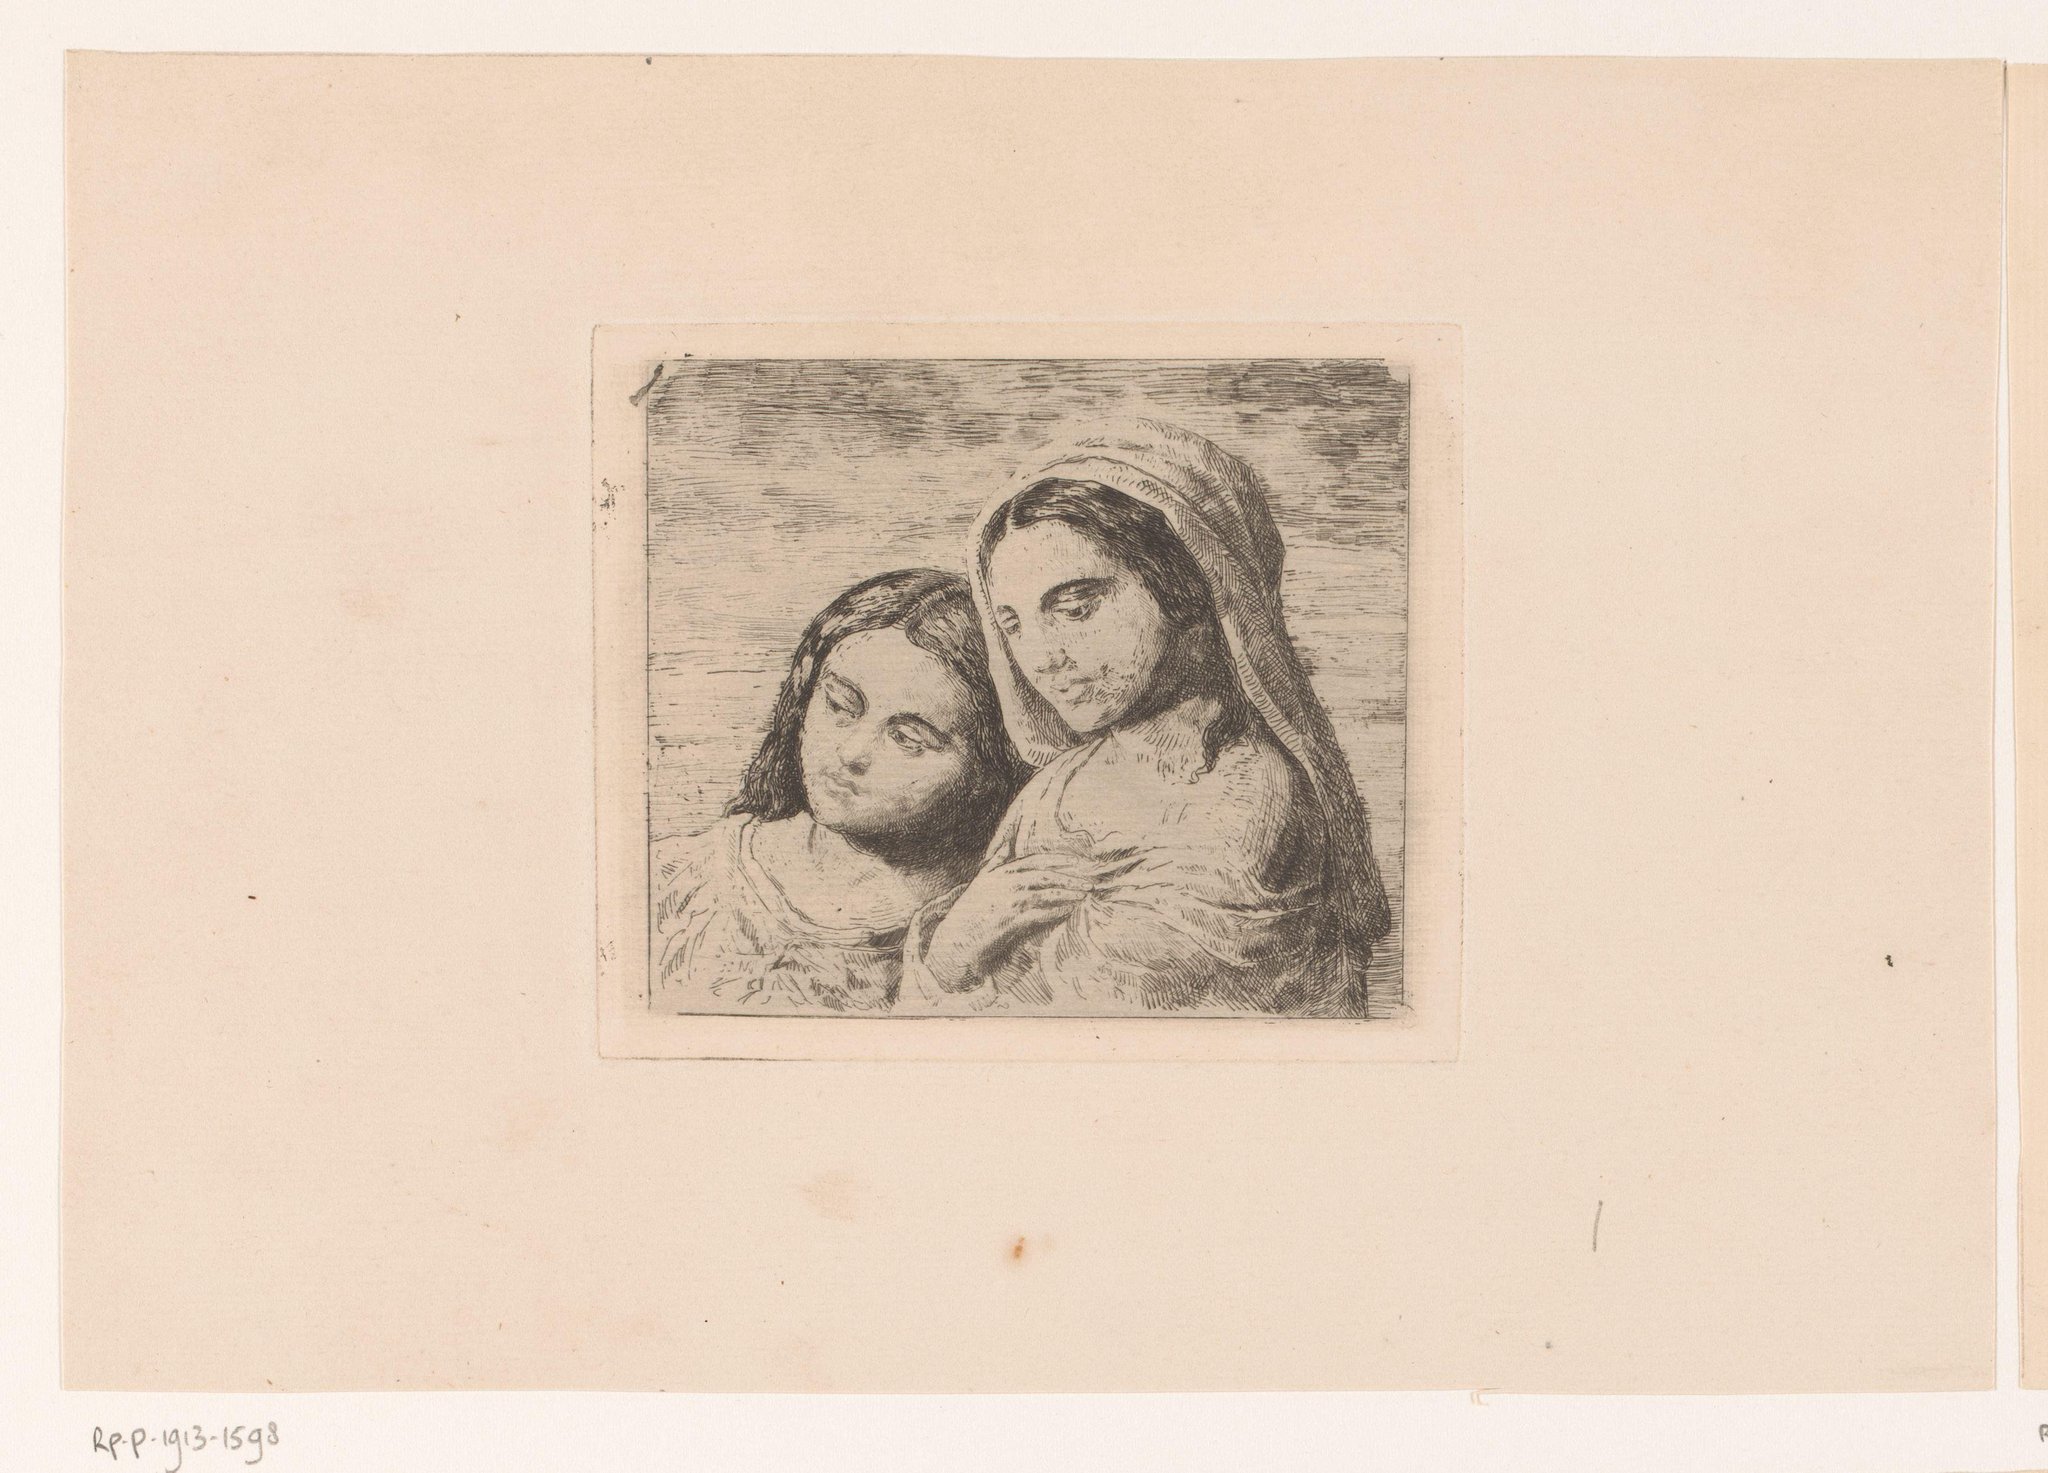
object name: print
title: Jonge vrouw en een meisje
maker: joseph meganck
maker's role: print maker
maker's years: 1807-1891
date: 1817-1891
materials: paper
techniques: etching, intaglio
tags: adolescent, young woman, maiden, girl (child between toddler and youth)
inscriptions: collector's mark: Lugt 2228